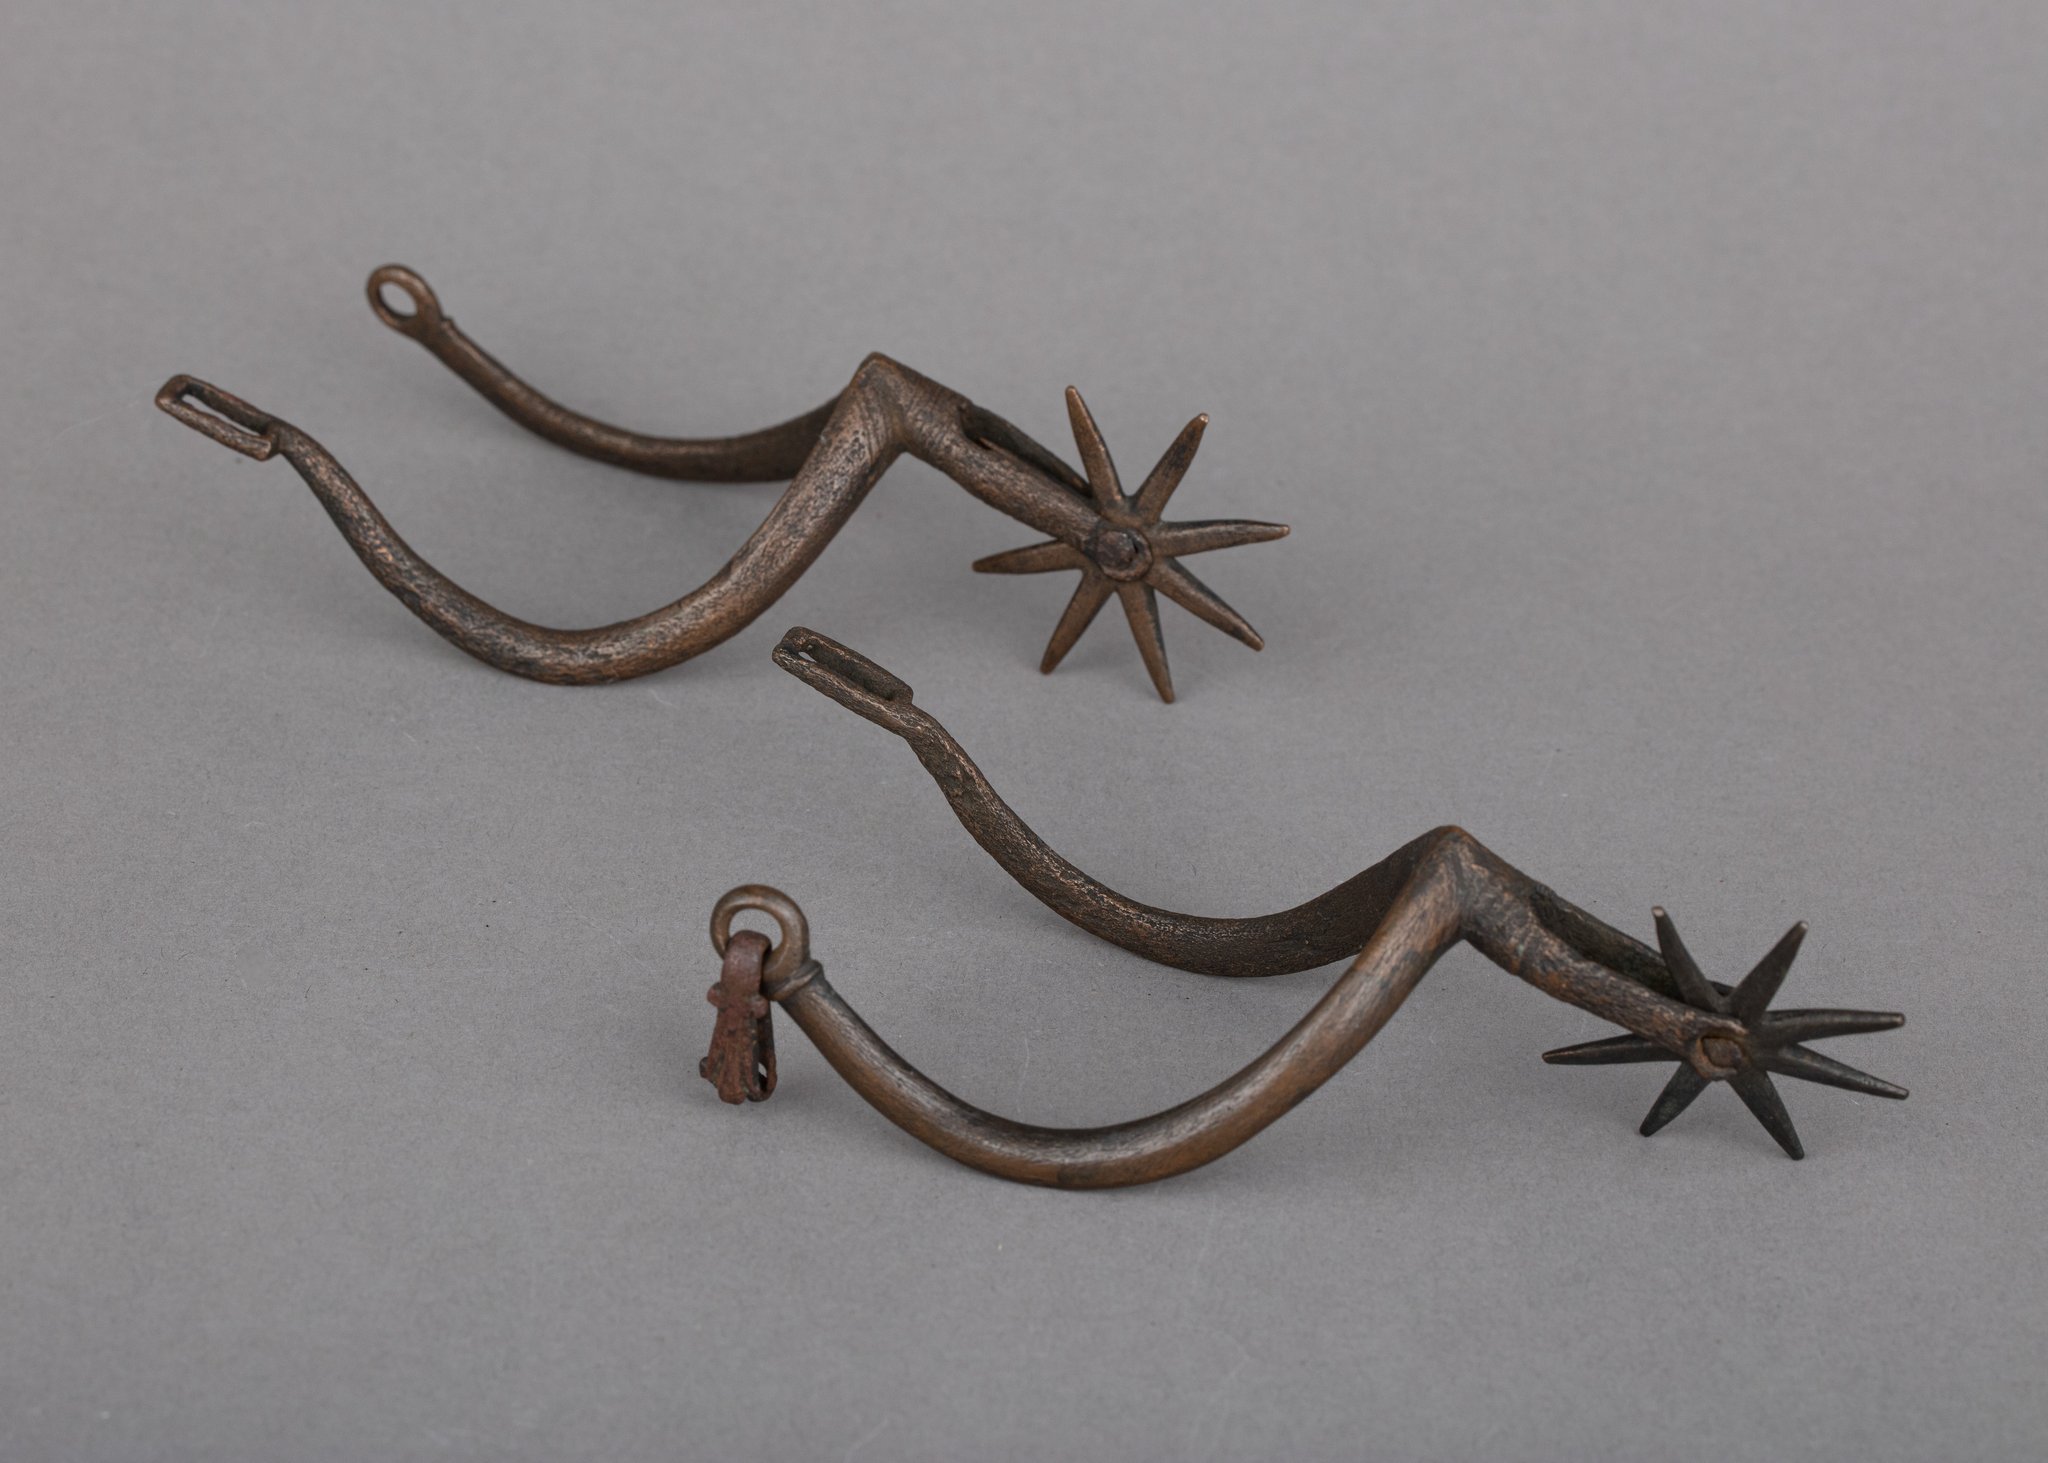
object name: spur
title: Pair of Rowel Spurs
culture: french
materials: copper alloy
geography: france